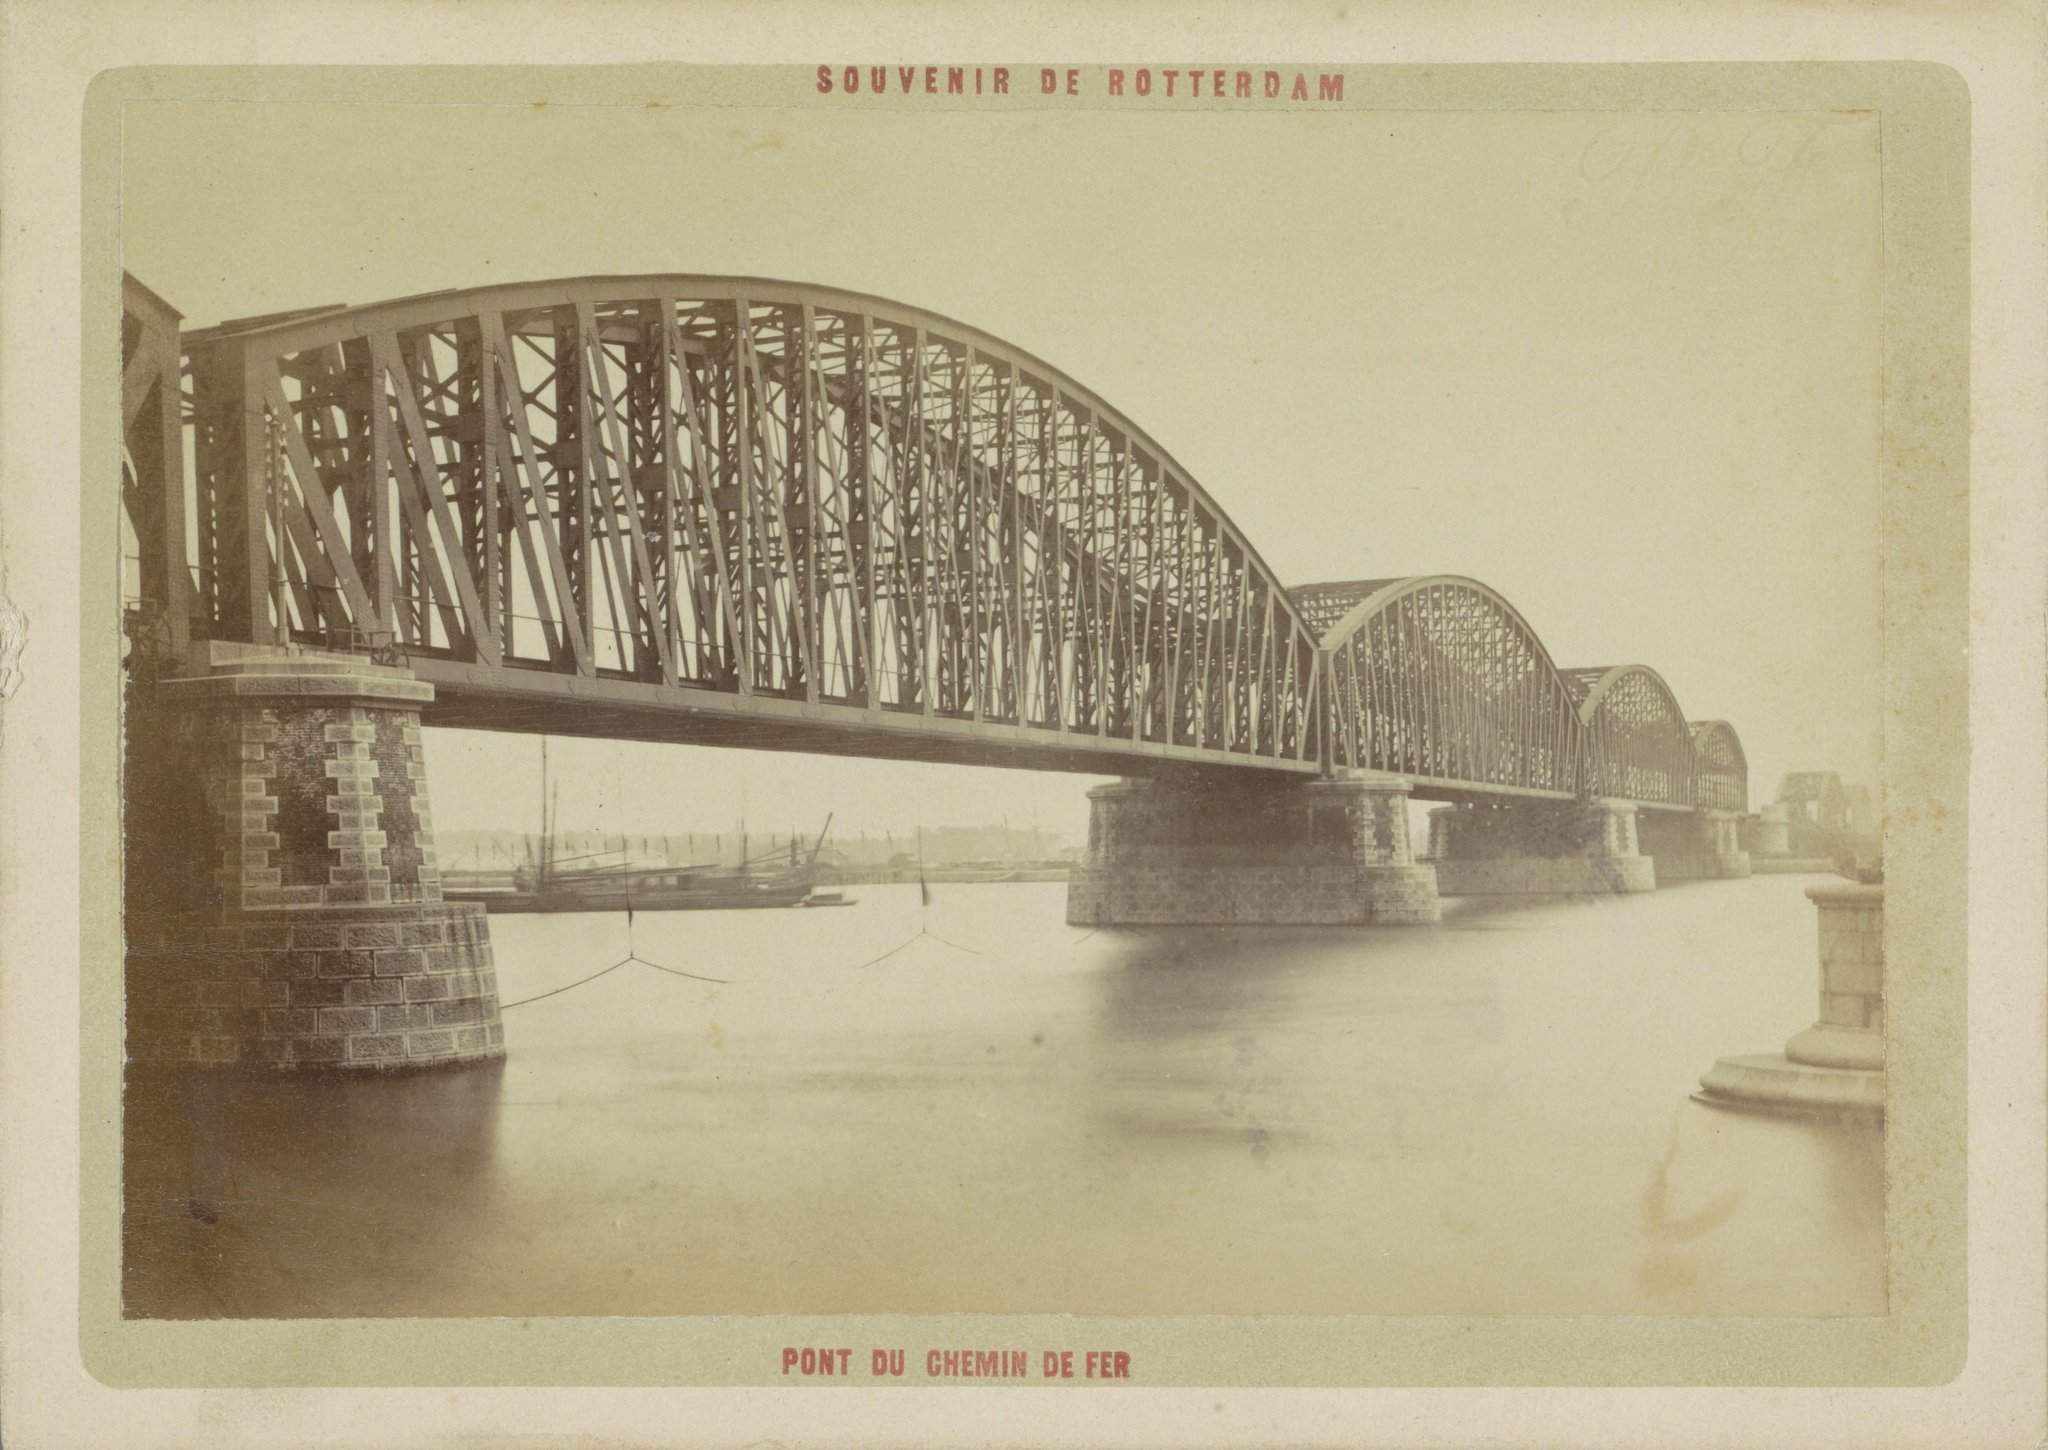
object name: cabinet photograph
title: Gezicht op de Willemsspoorbrug over de Maas in Rotterdam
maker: Anonymous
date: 1877-1880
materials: cardboard, photographic support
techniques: albumen print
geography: rotterdam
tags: bridge in city across river, canal, etc., rotterdam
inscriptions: inscription: ‘Spoorwegbrug over de Maas.’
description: Onderdeel van Verzamelband met foto's van Rotterdam.